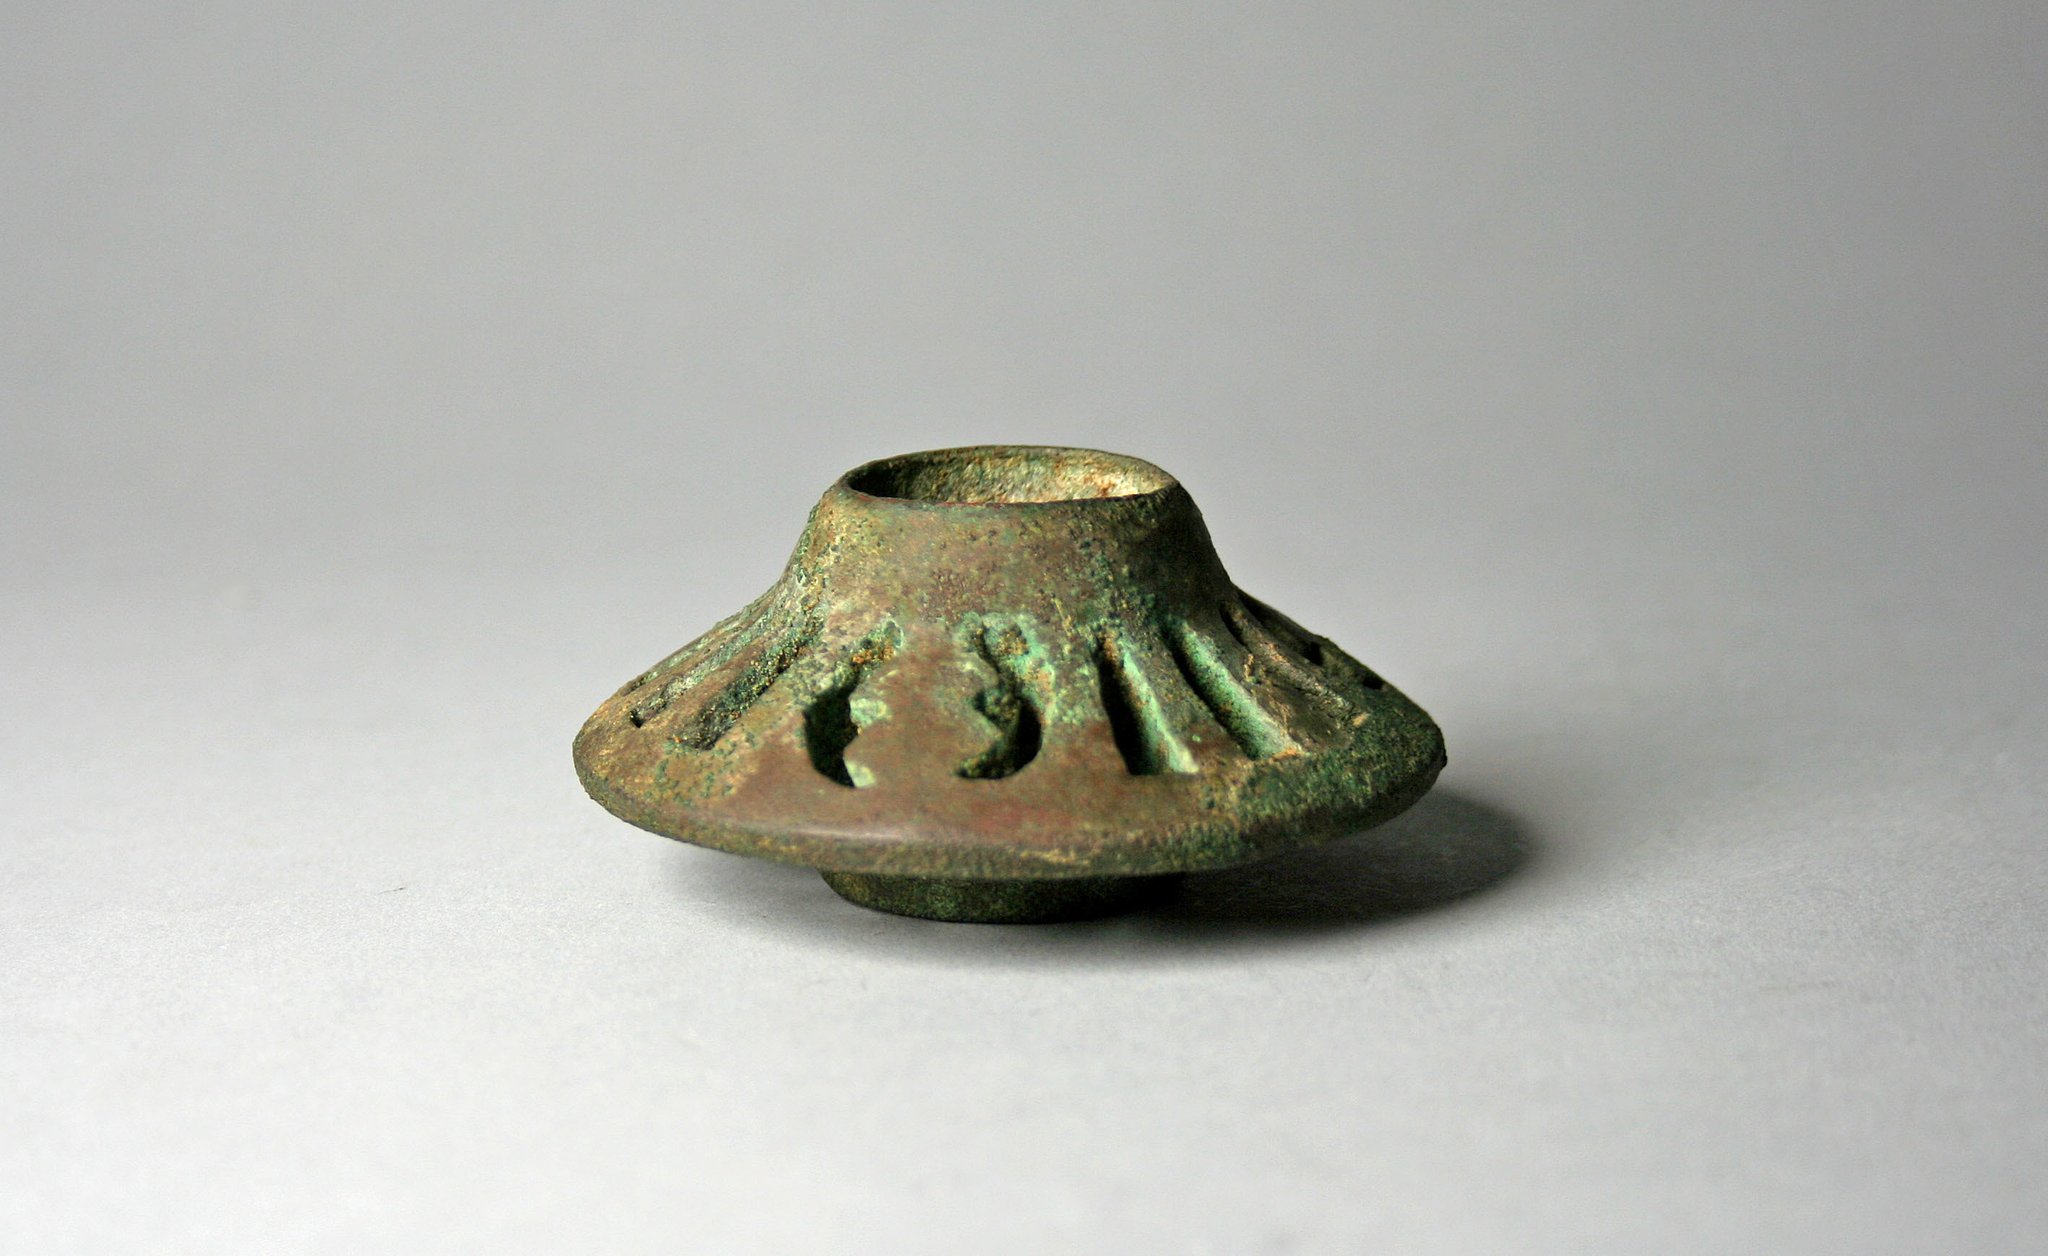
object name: mace head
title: Copper Openwork Mace Head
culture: vicús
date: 300 BCE-200 CE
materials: copper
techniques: casting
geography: peru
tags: weapons